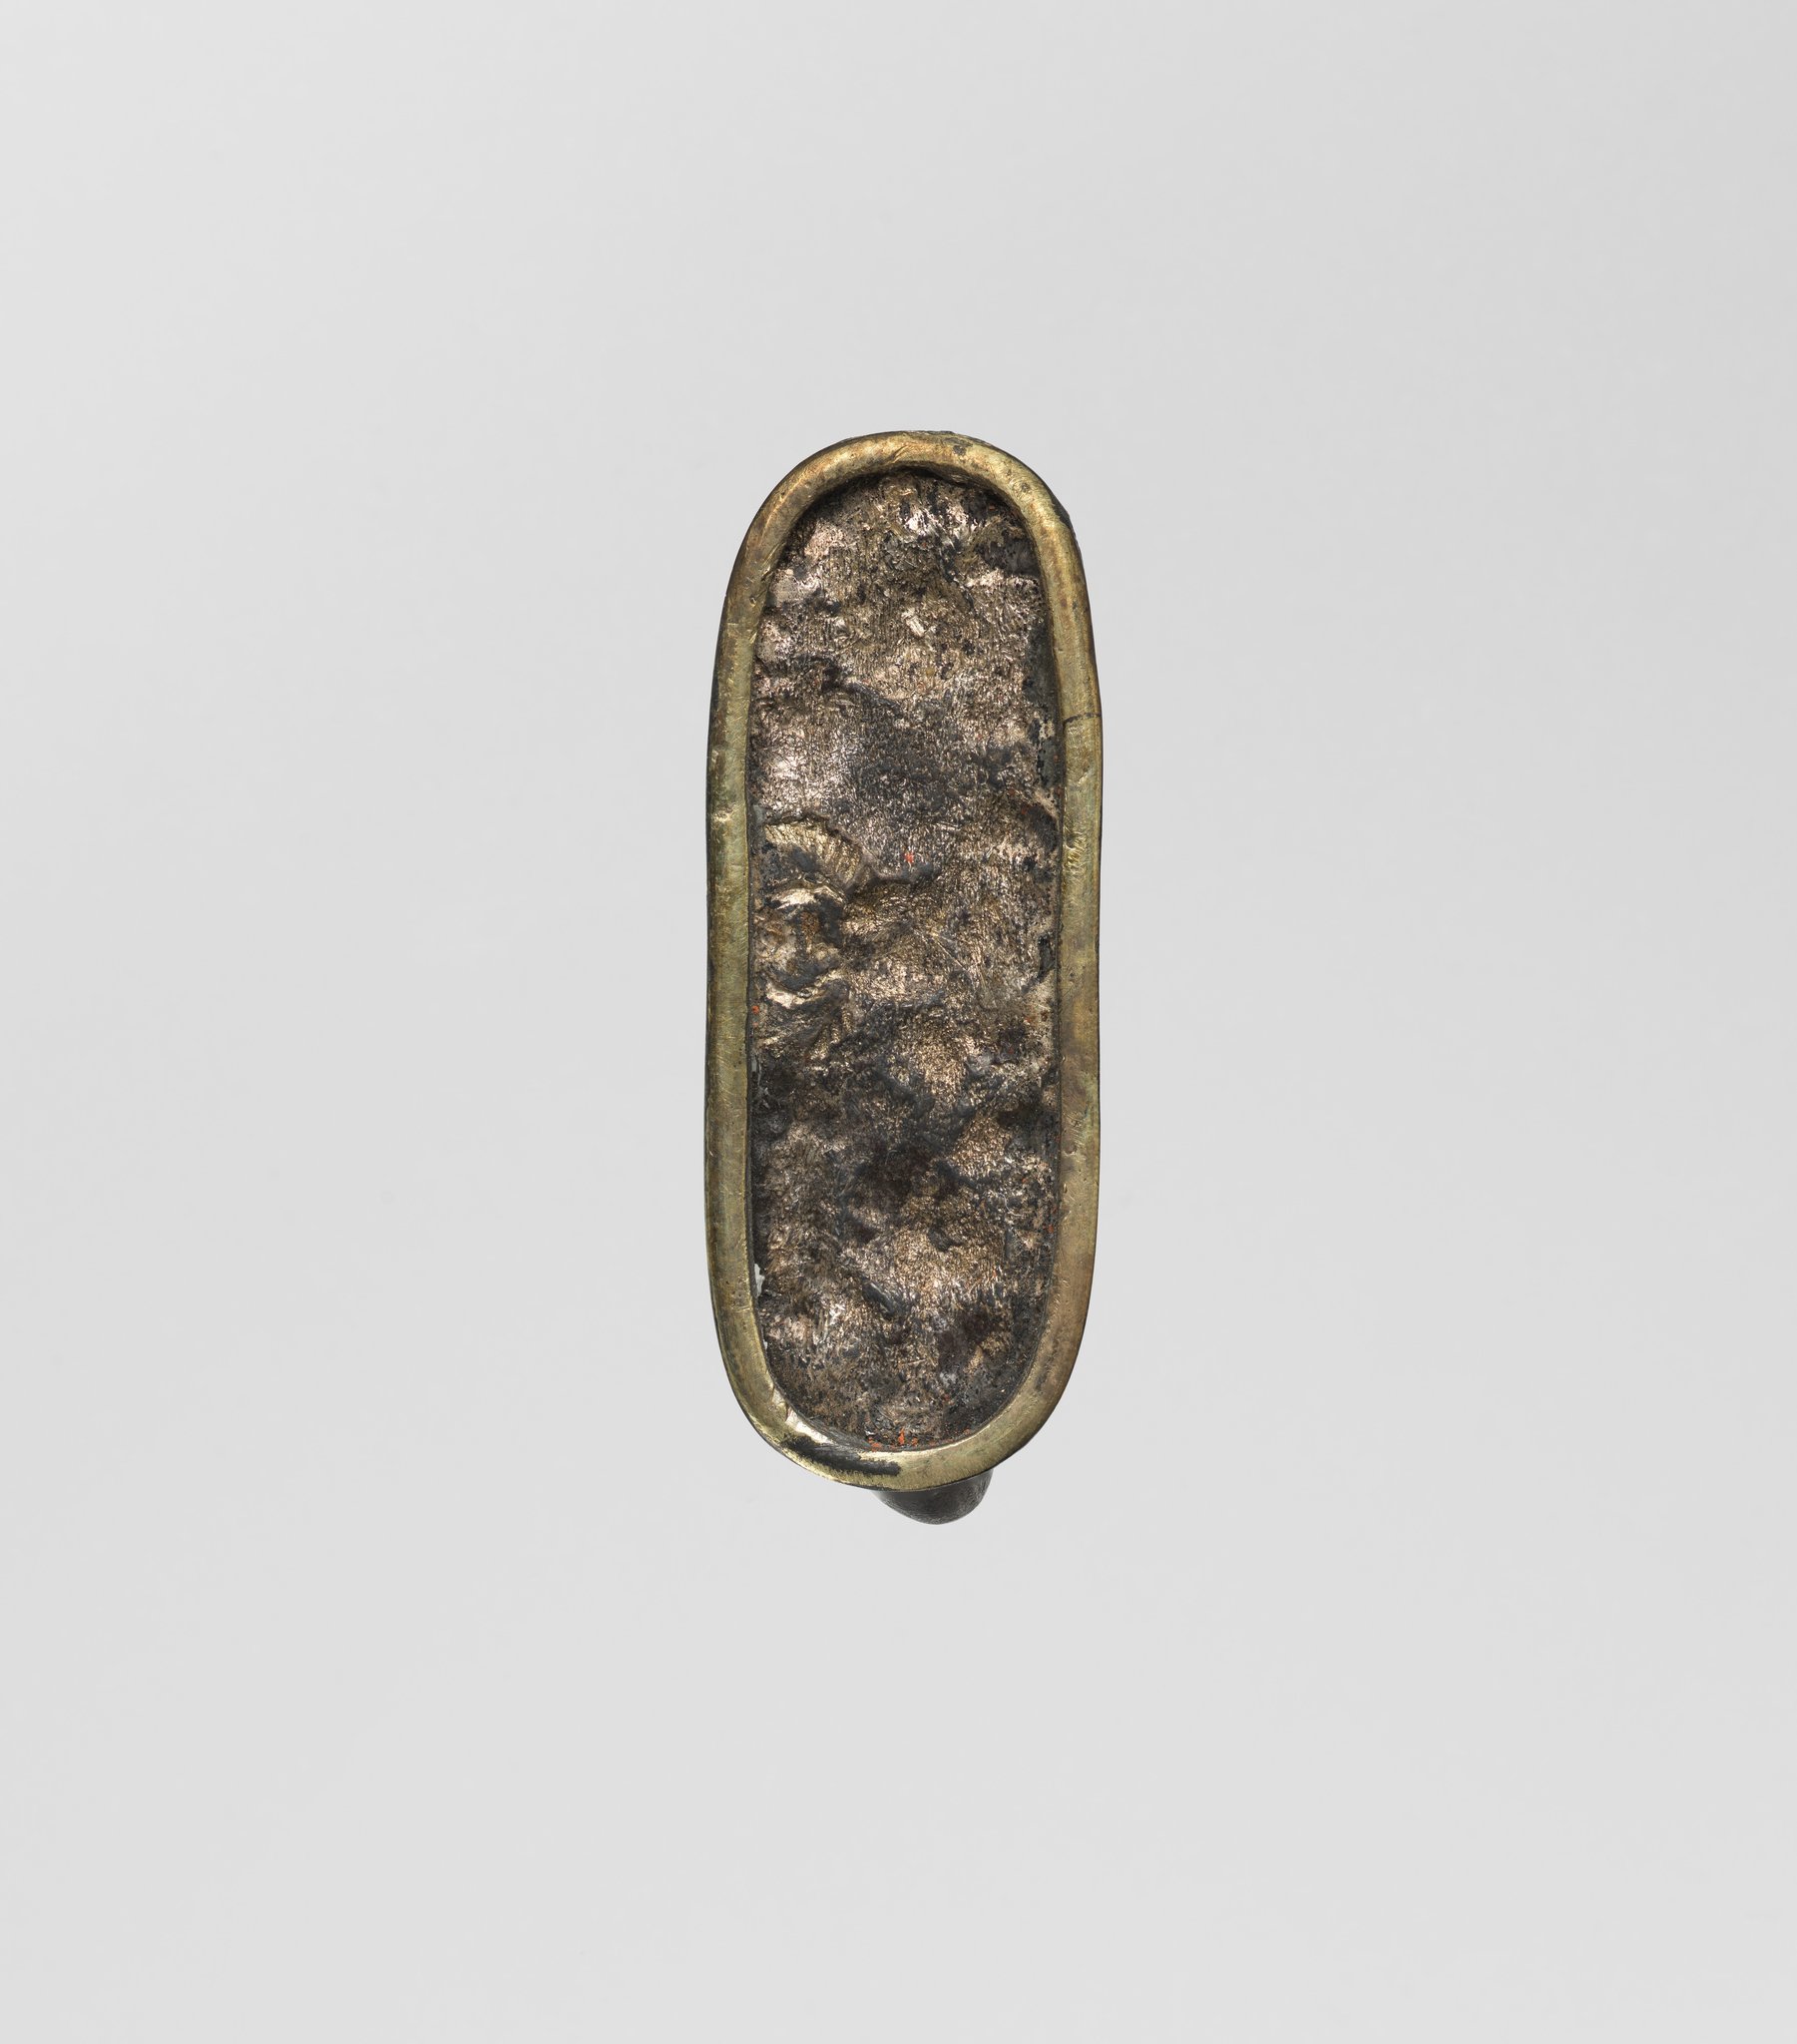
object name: ring, empty bezel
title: Ring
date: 1070-712 BCE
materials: bronze, copper alloy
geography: egypt